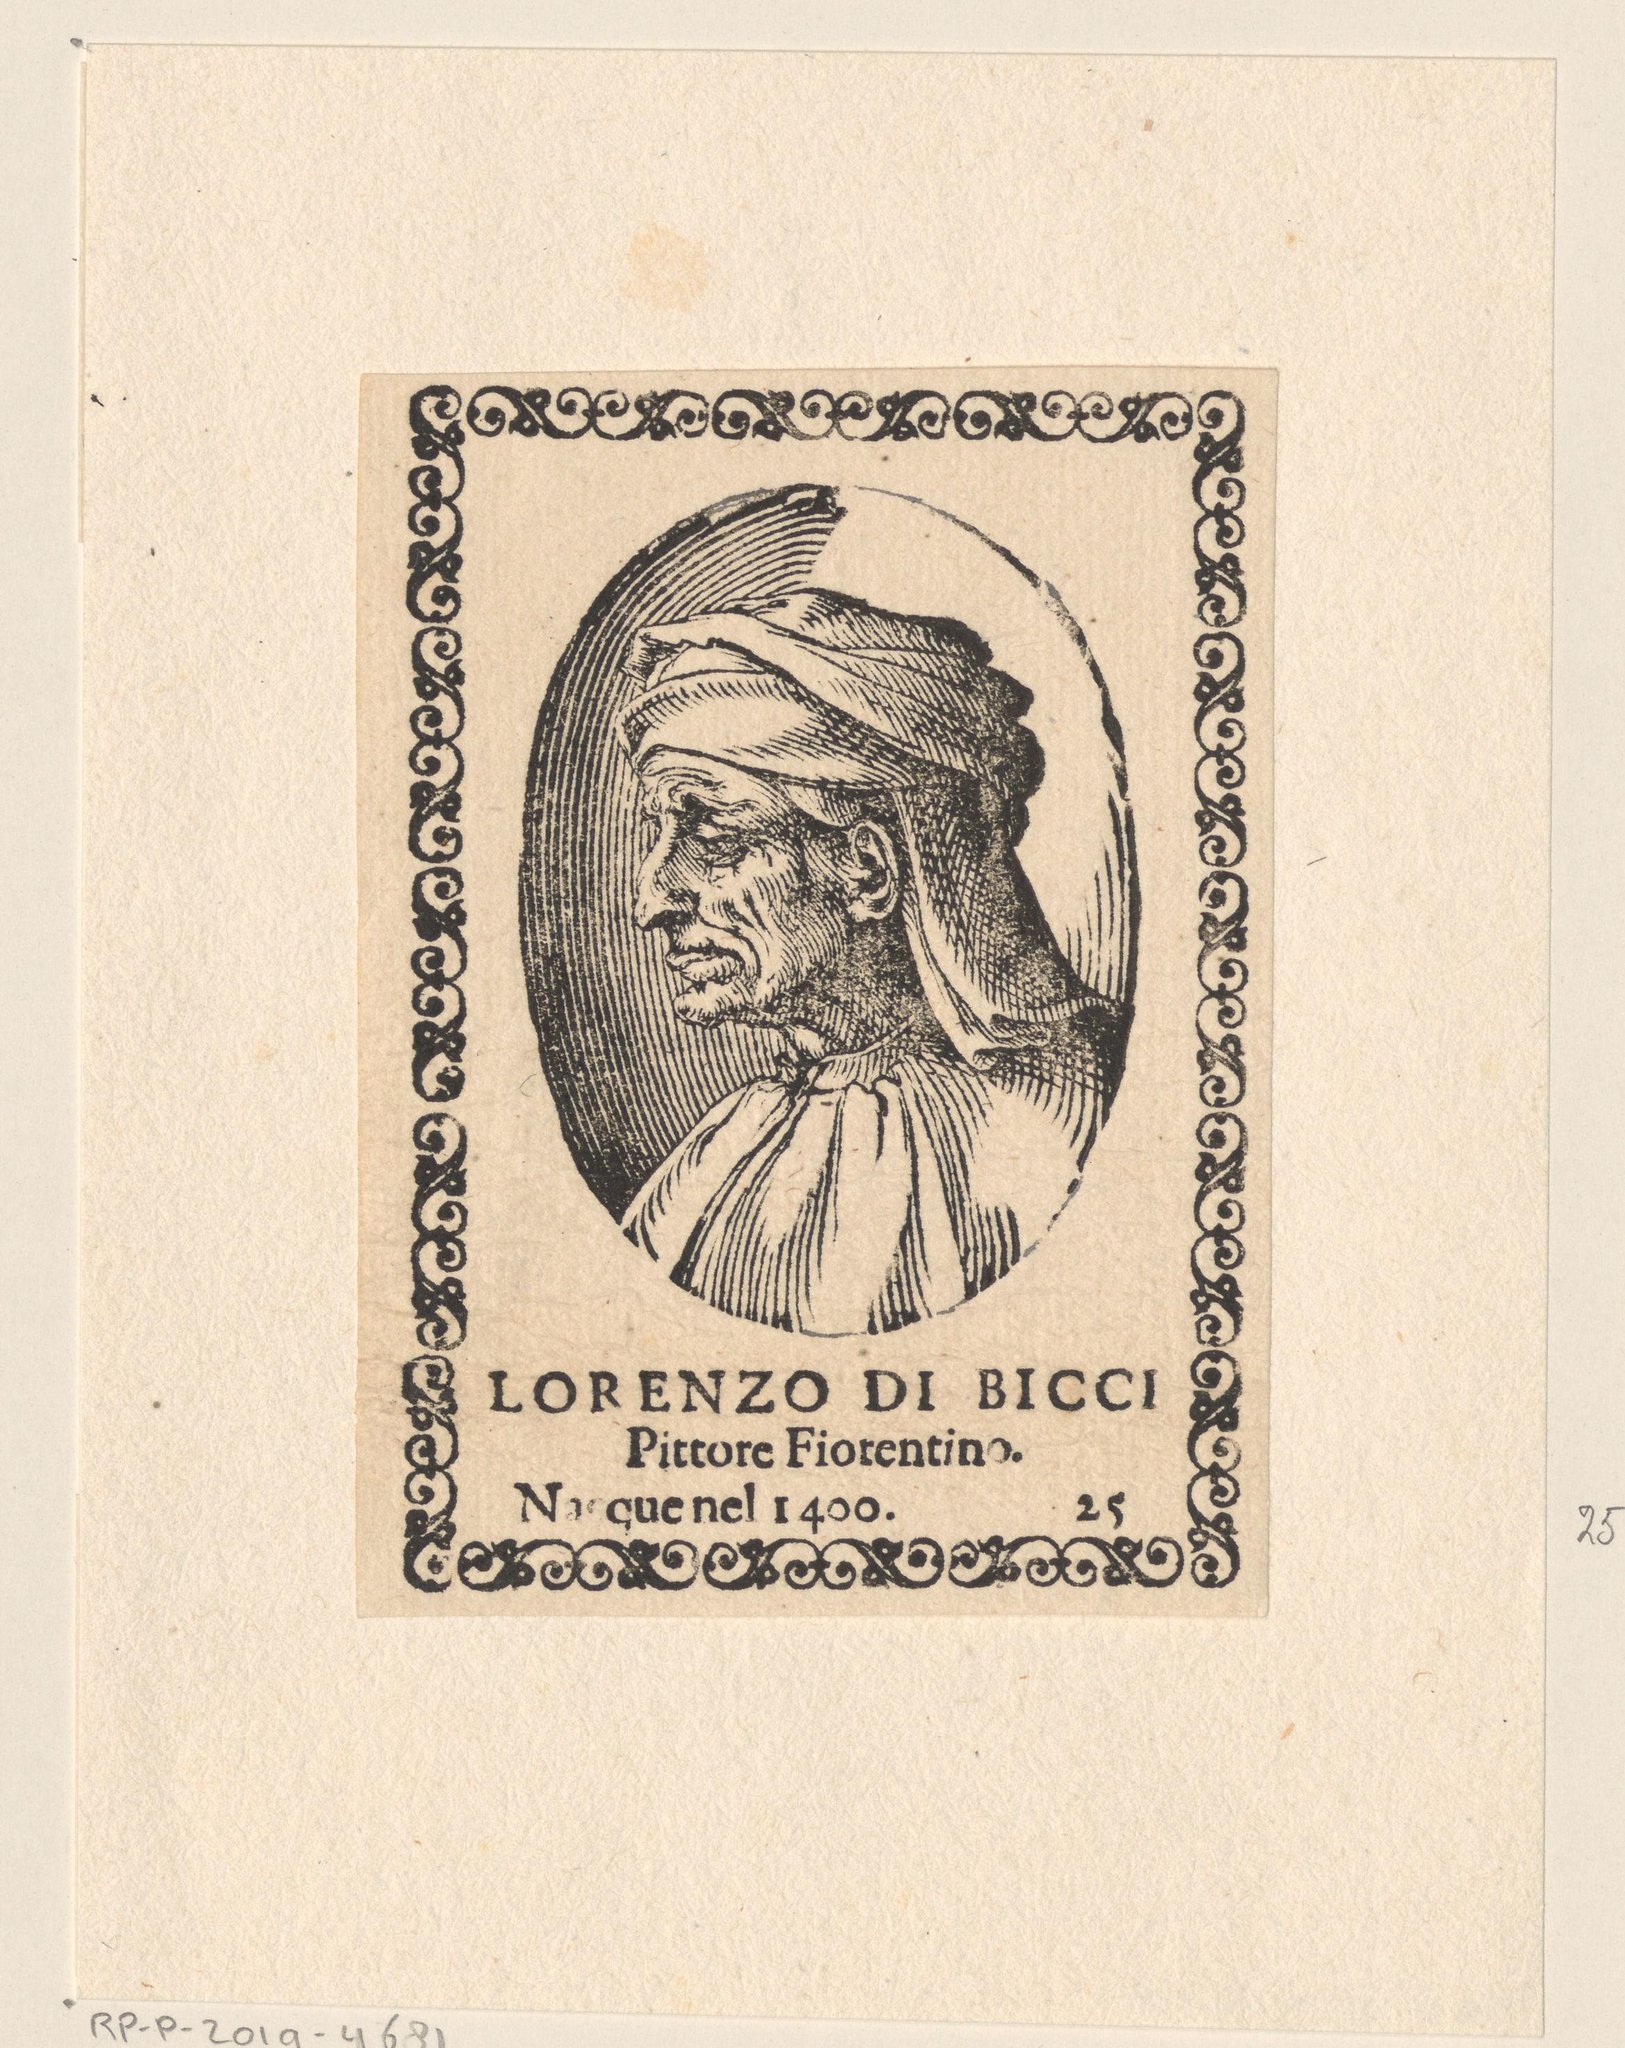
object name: print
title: Portret van Lorenzo di Bicci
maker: Anonymous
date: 1600-1699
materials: paper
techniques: letterpress printing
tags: painter, lorenzo di bicci, historical persons, portrait, self-portrait of painter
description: Prent waarschijnlijk afkomstig uit een Italiaanse editie van: Vasari, Giorgio. Vite de' più eccellenti architetti, pittori, et scultori italiani (...).